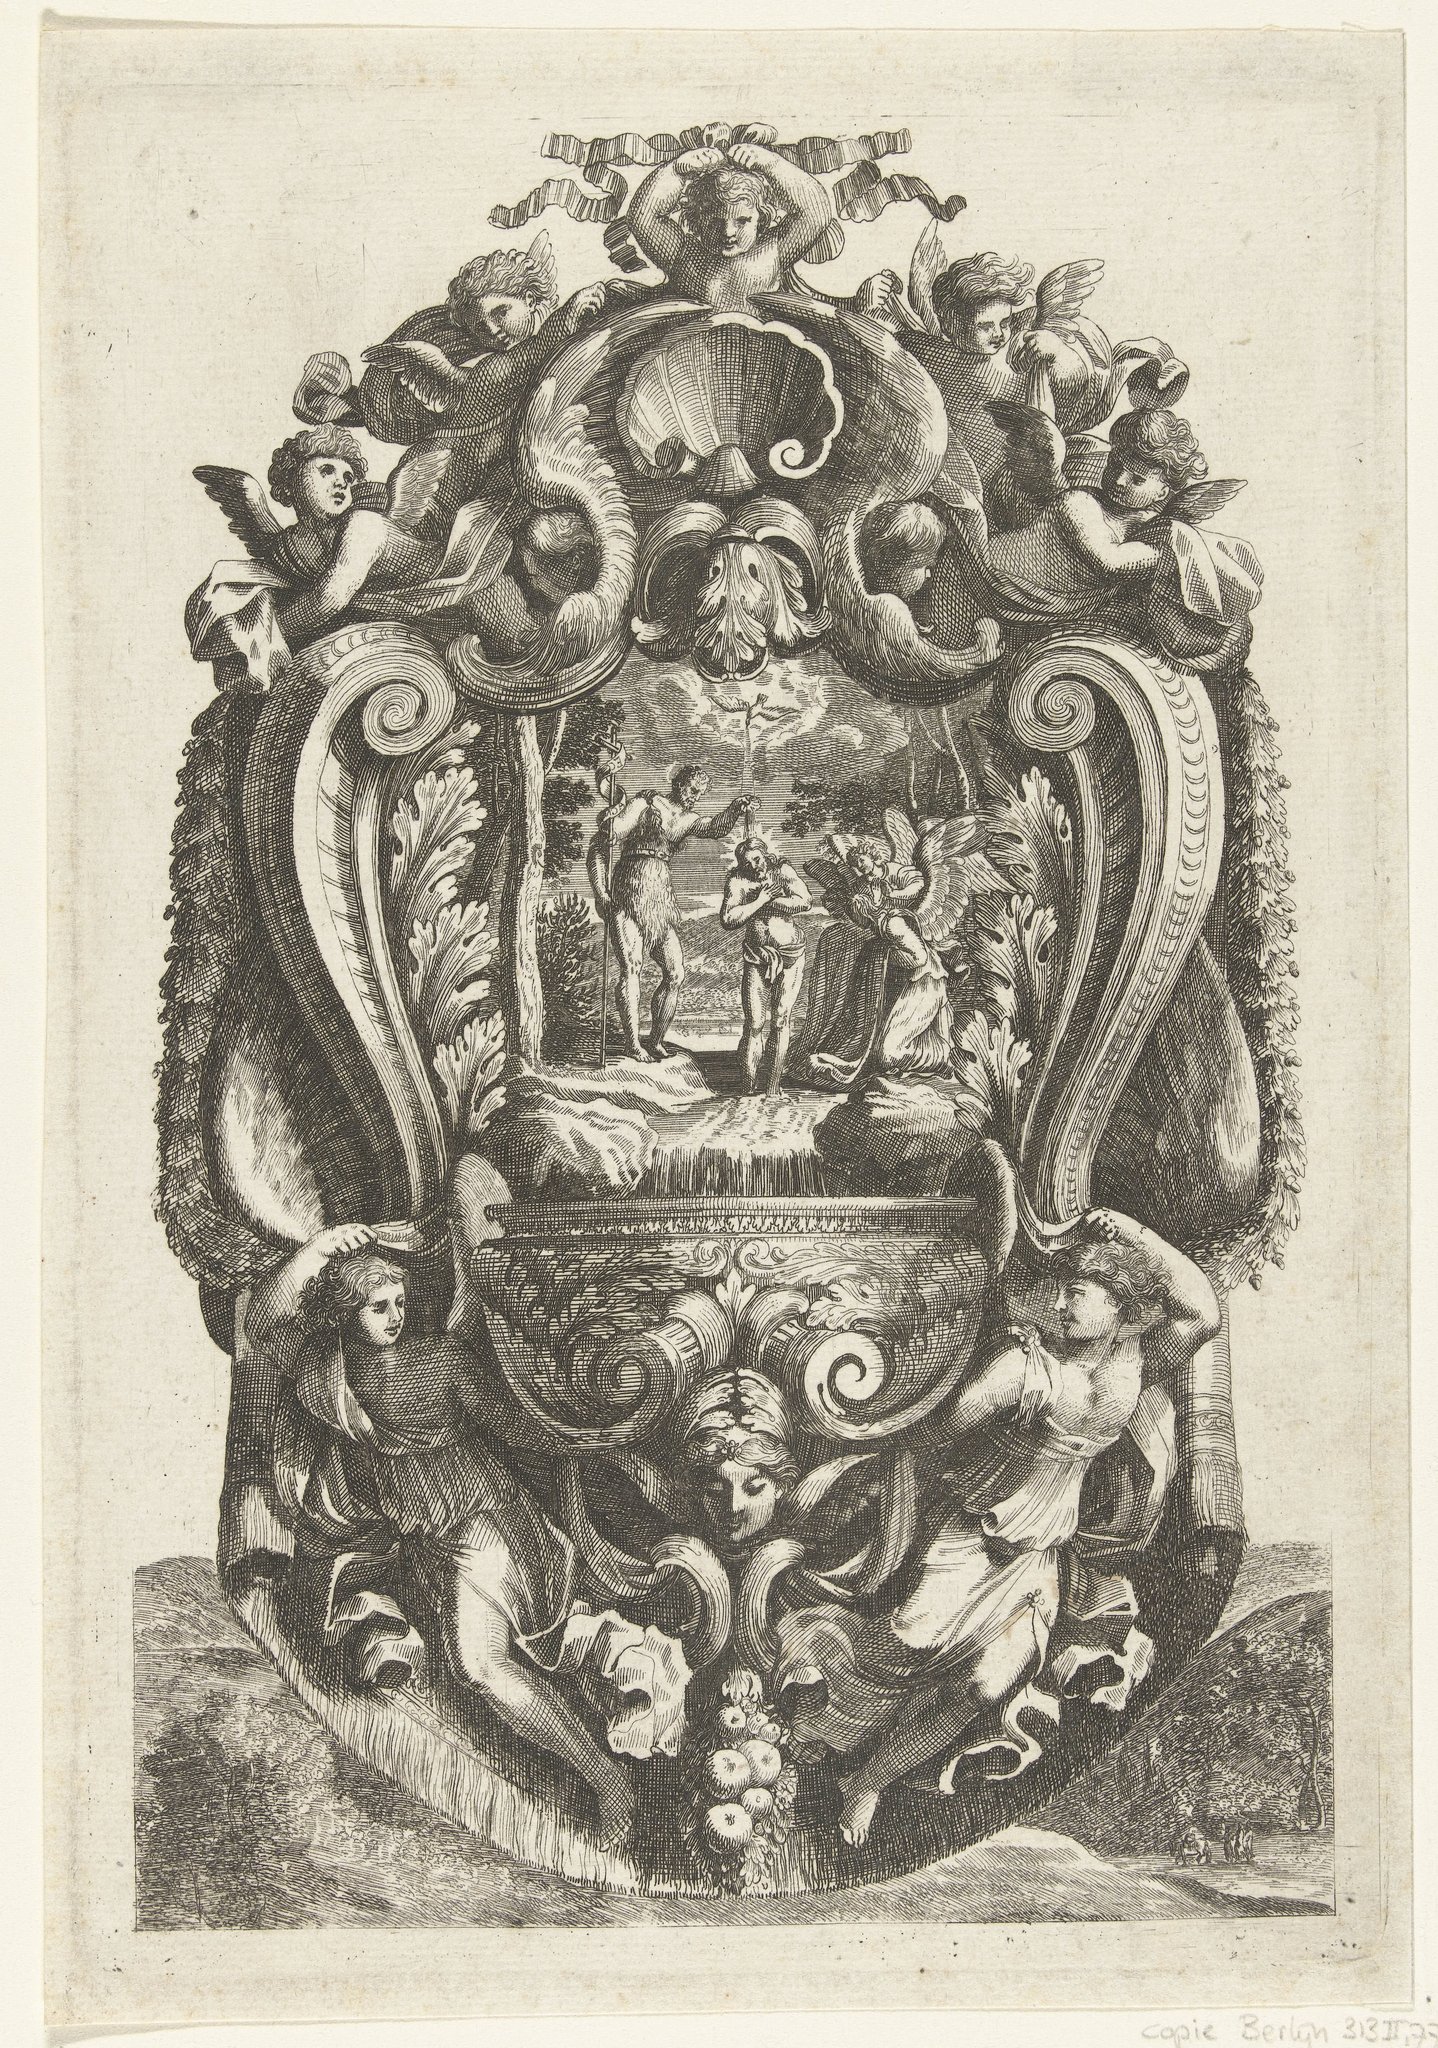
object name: ornament print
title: Wijwaterbak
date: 1677-1692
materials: paper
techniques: etching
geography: antwerp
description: De wijwaterbak wordt ondersteund door twee engelen aan weerskanten van een masker. Op de achterplaat staat de Doop van Christus. Uit serie van 6 bladen.